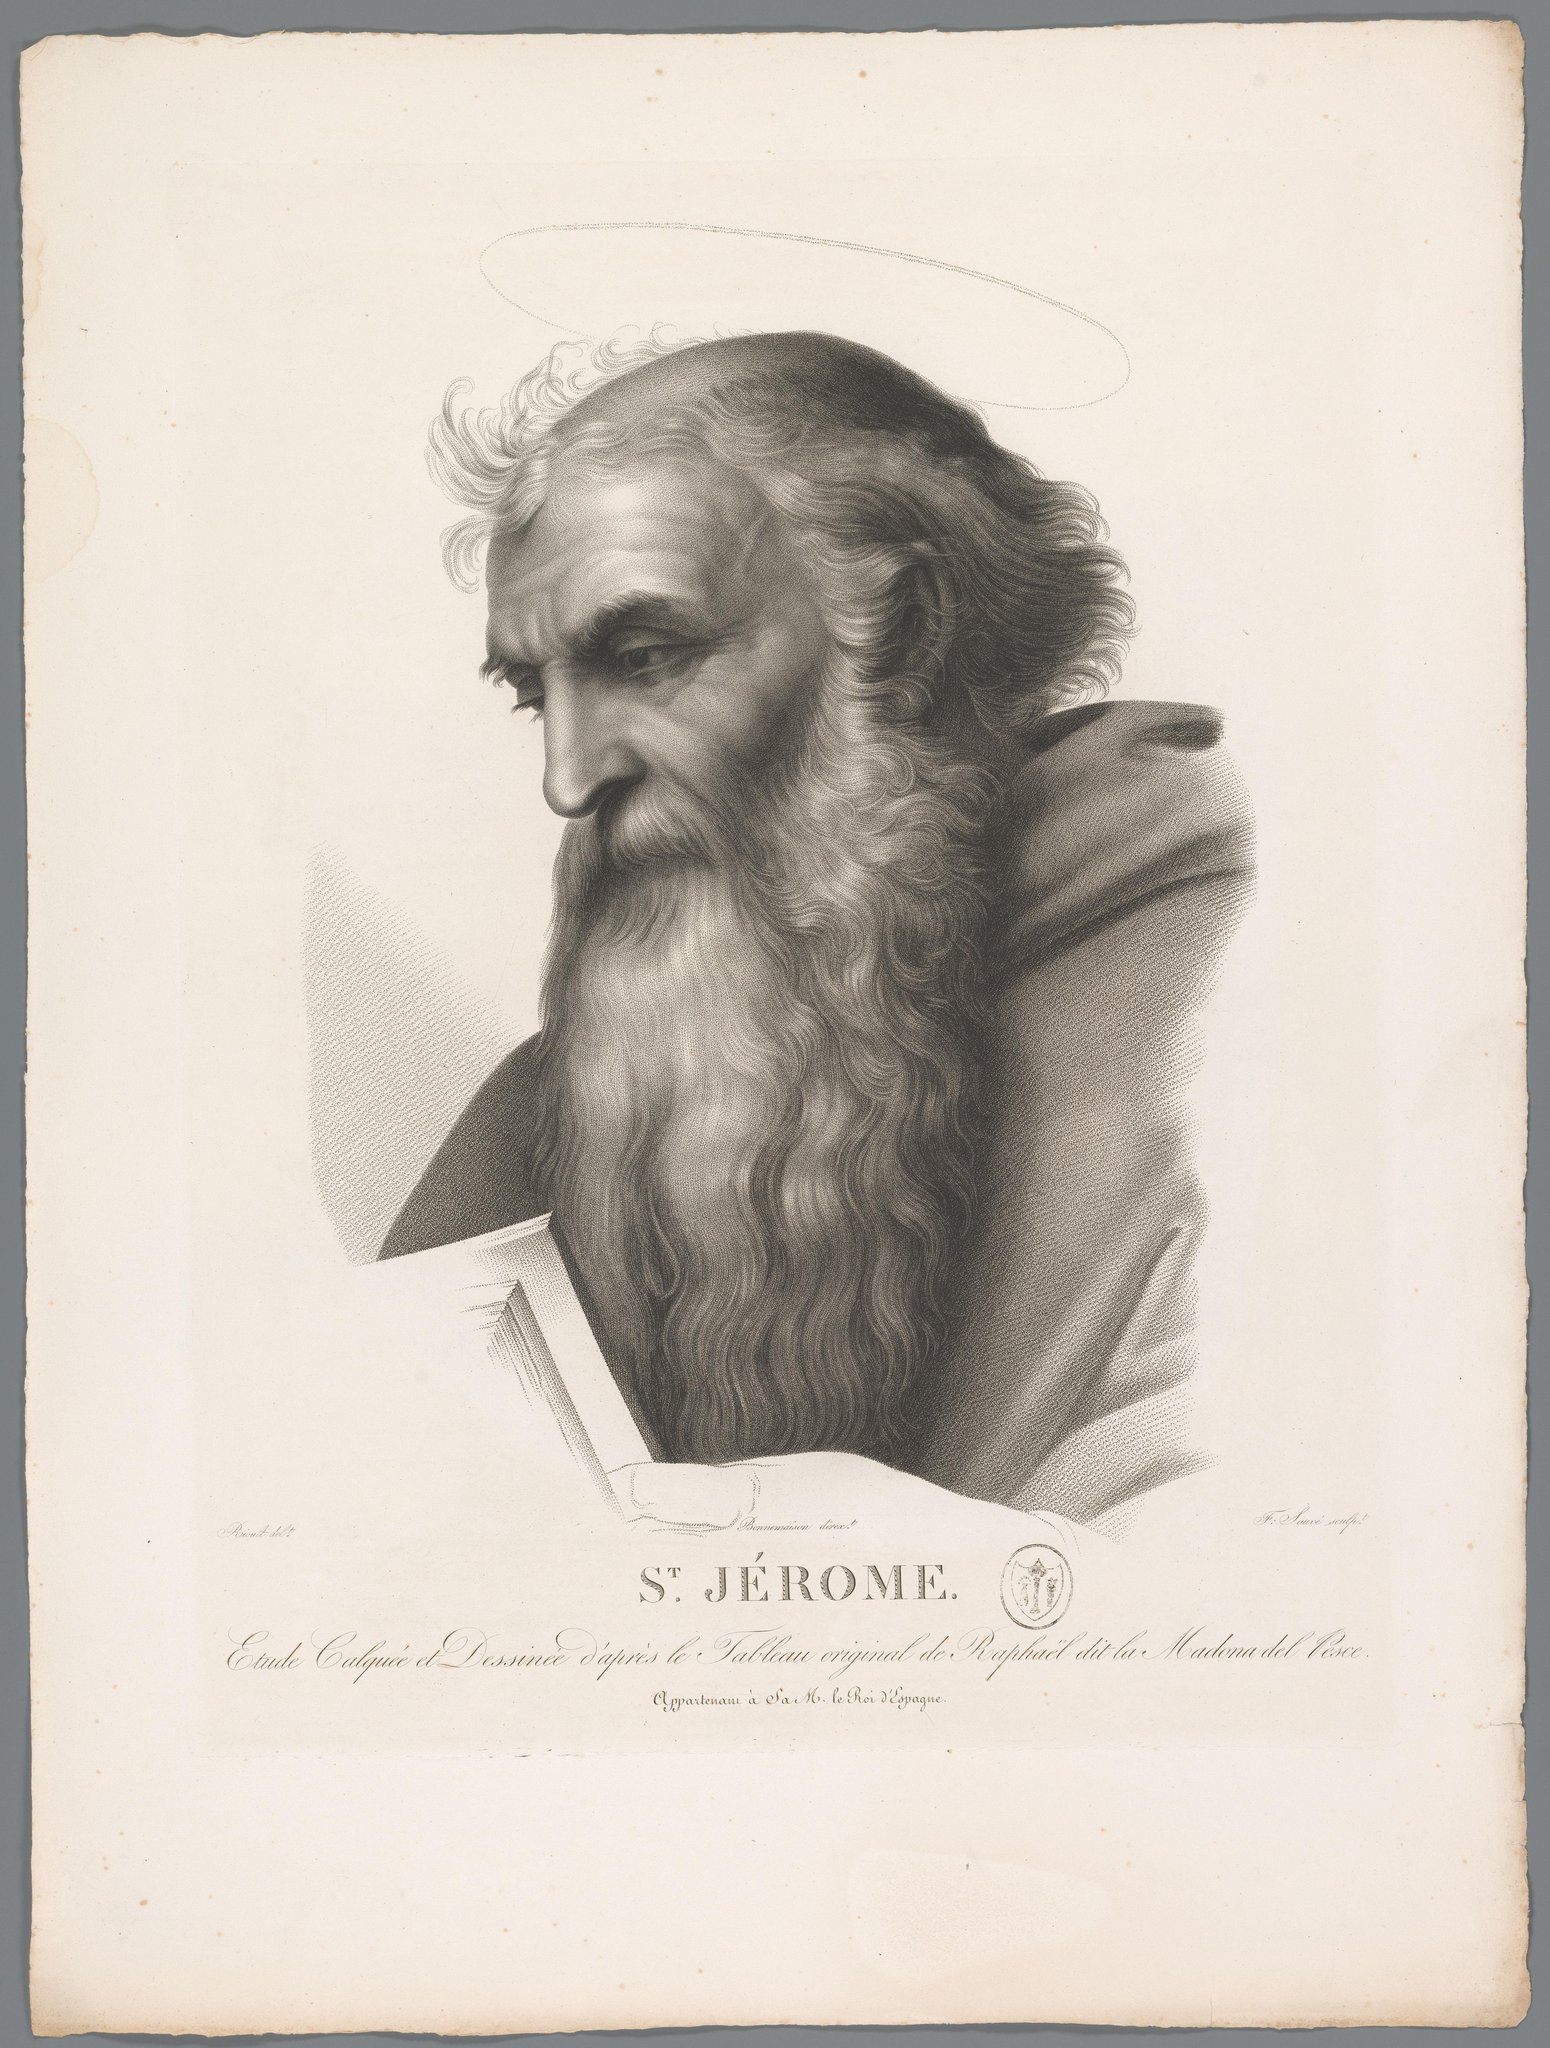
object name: print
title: H. Hieronymus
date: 1818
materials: paper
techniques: printmaking, engraving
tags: the monk and hermit jerome (hieronymus); possible attributes: book, cardinal's hat, crucifix, hour-glass, lion, skull, stone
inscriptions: collector's mark: Lugt 4583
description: Maakt deel uit van een omslag met 8 prenten en 5 tekstbladen naar details van schilderijen door Rafaël. De serie kwam tot stand onder toezicht van Féréol Bonnemaison en werd voorzien van tekst door Toussaint-Bernard Émeric-David. Het geheel werd uitgegeven door Féréol Bonnemaison en Mesdemoiselles Érard te Parijs en gedrukt door Pierre I Didot in 1818. Dit betreft een detail van Tobias en de engel bij Maria met kind en de H. Hieronymus, dat zich in de collectie van het Museo del Prado in Madrid, inv.nr. P000297, ook wel bekend als de 'Madonna del Pesce'.